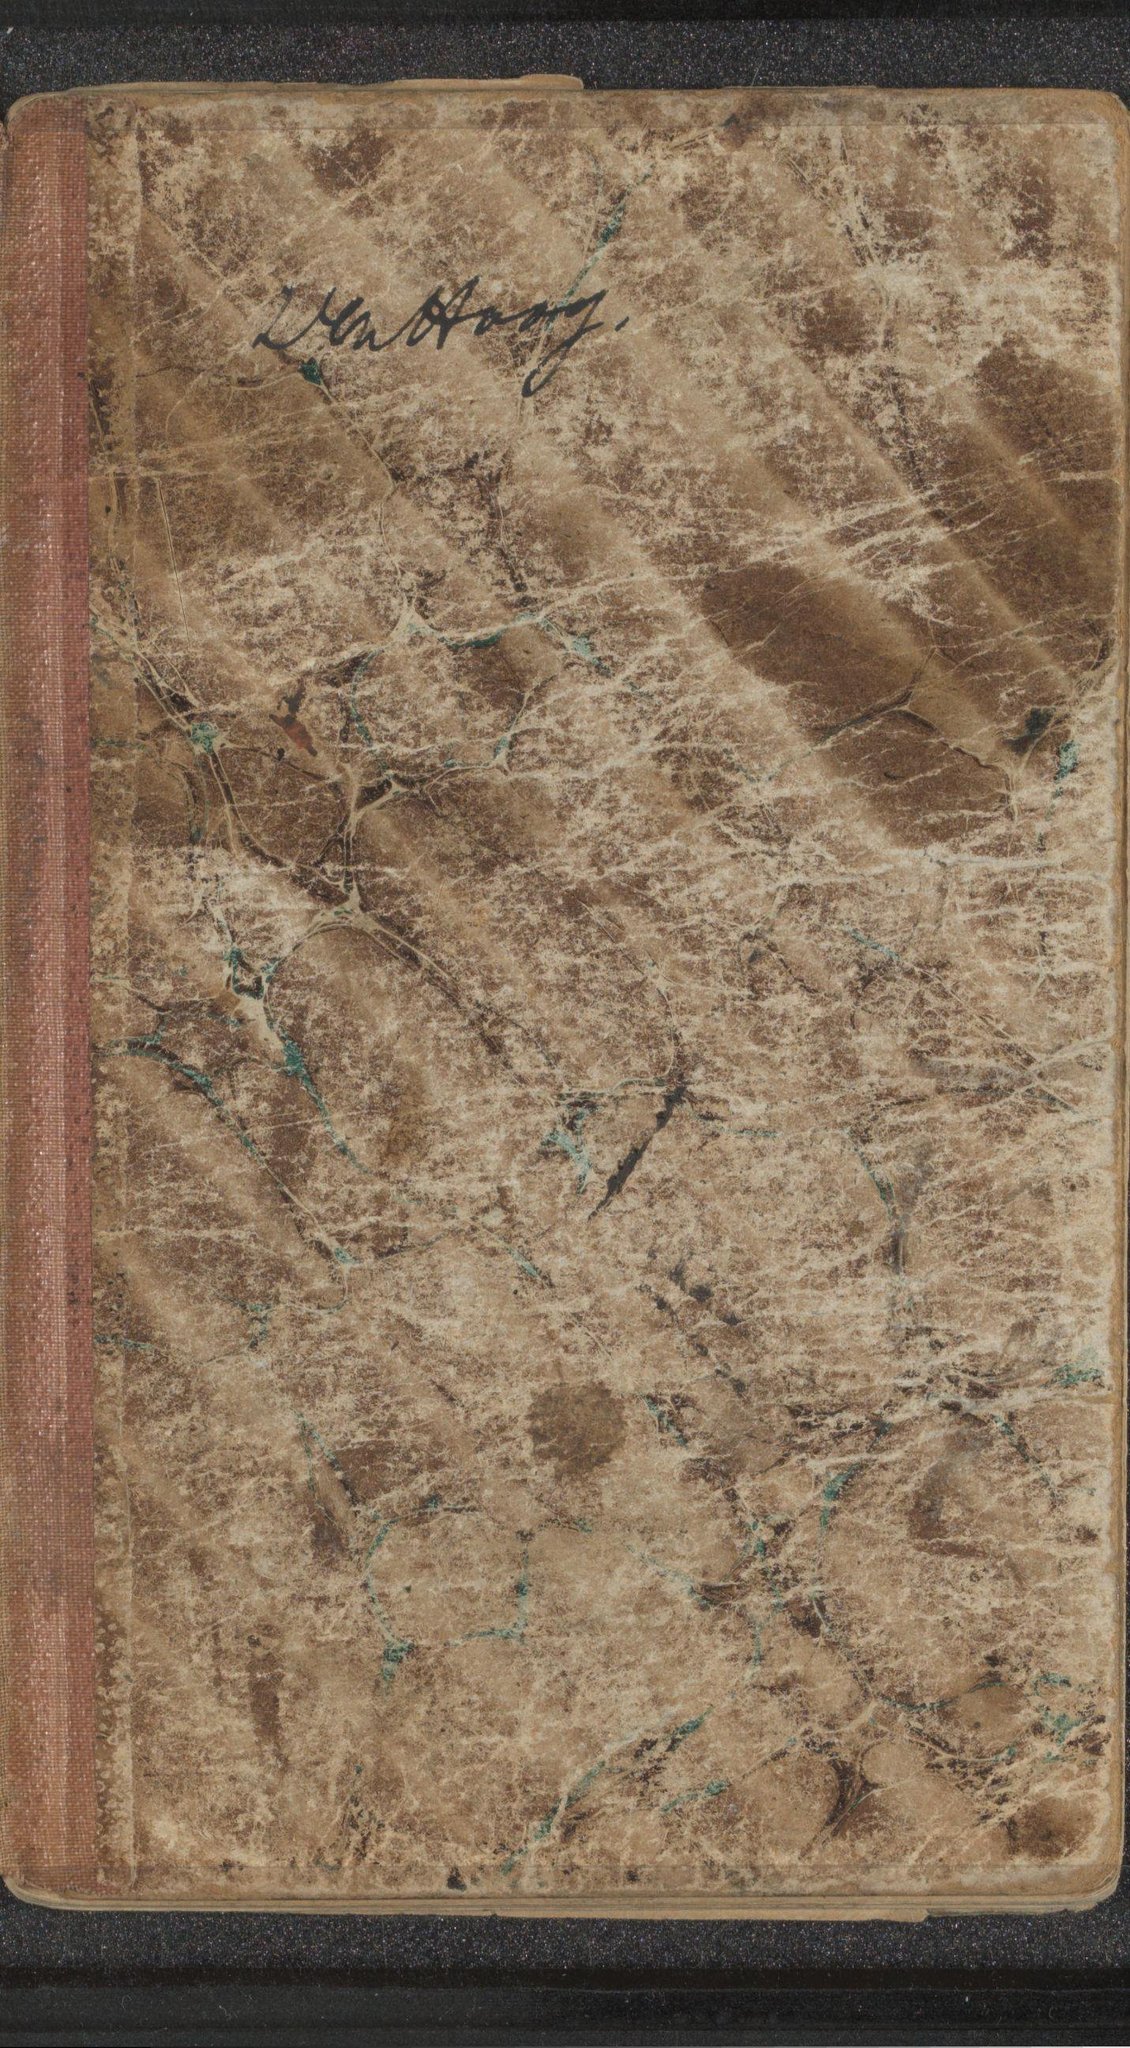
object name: sketchbook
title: Schetsboek met 19 bladen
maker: george hendrik breitner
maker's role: draughtsman, painter, print maker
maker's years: 1857-1923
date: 1880-1882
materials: cardboard, chalk, linen, paper, pencil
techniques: marbling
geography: the hague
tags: riding a horse, ass, or mule; rider, horseman, adult woman, landscapes, animals, adult man, the hague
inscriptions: annotation: ‘Den Haag’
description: Schetsboek bestaande uit 19 bladen met voornamelijk figuurstudies, landschappen en dieren.